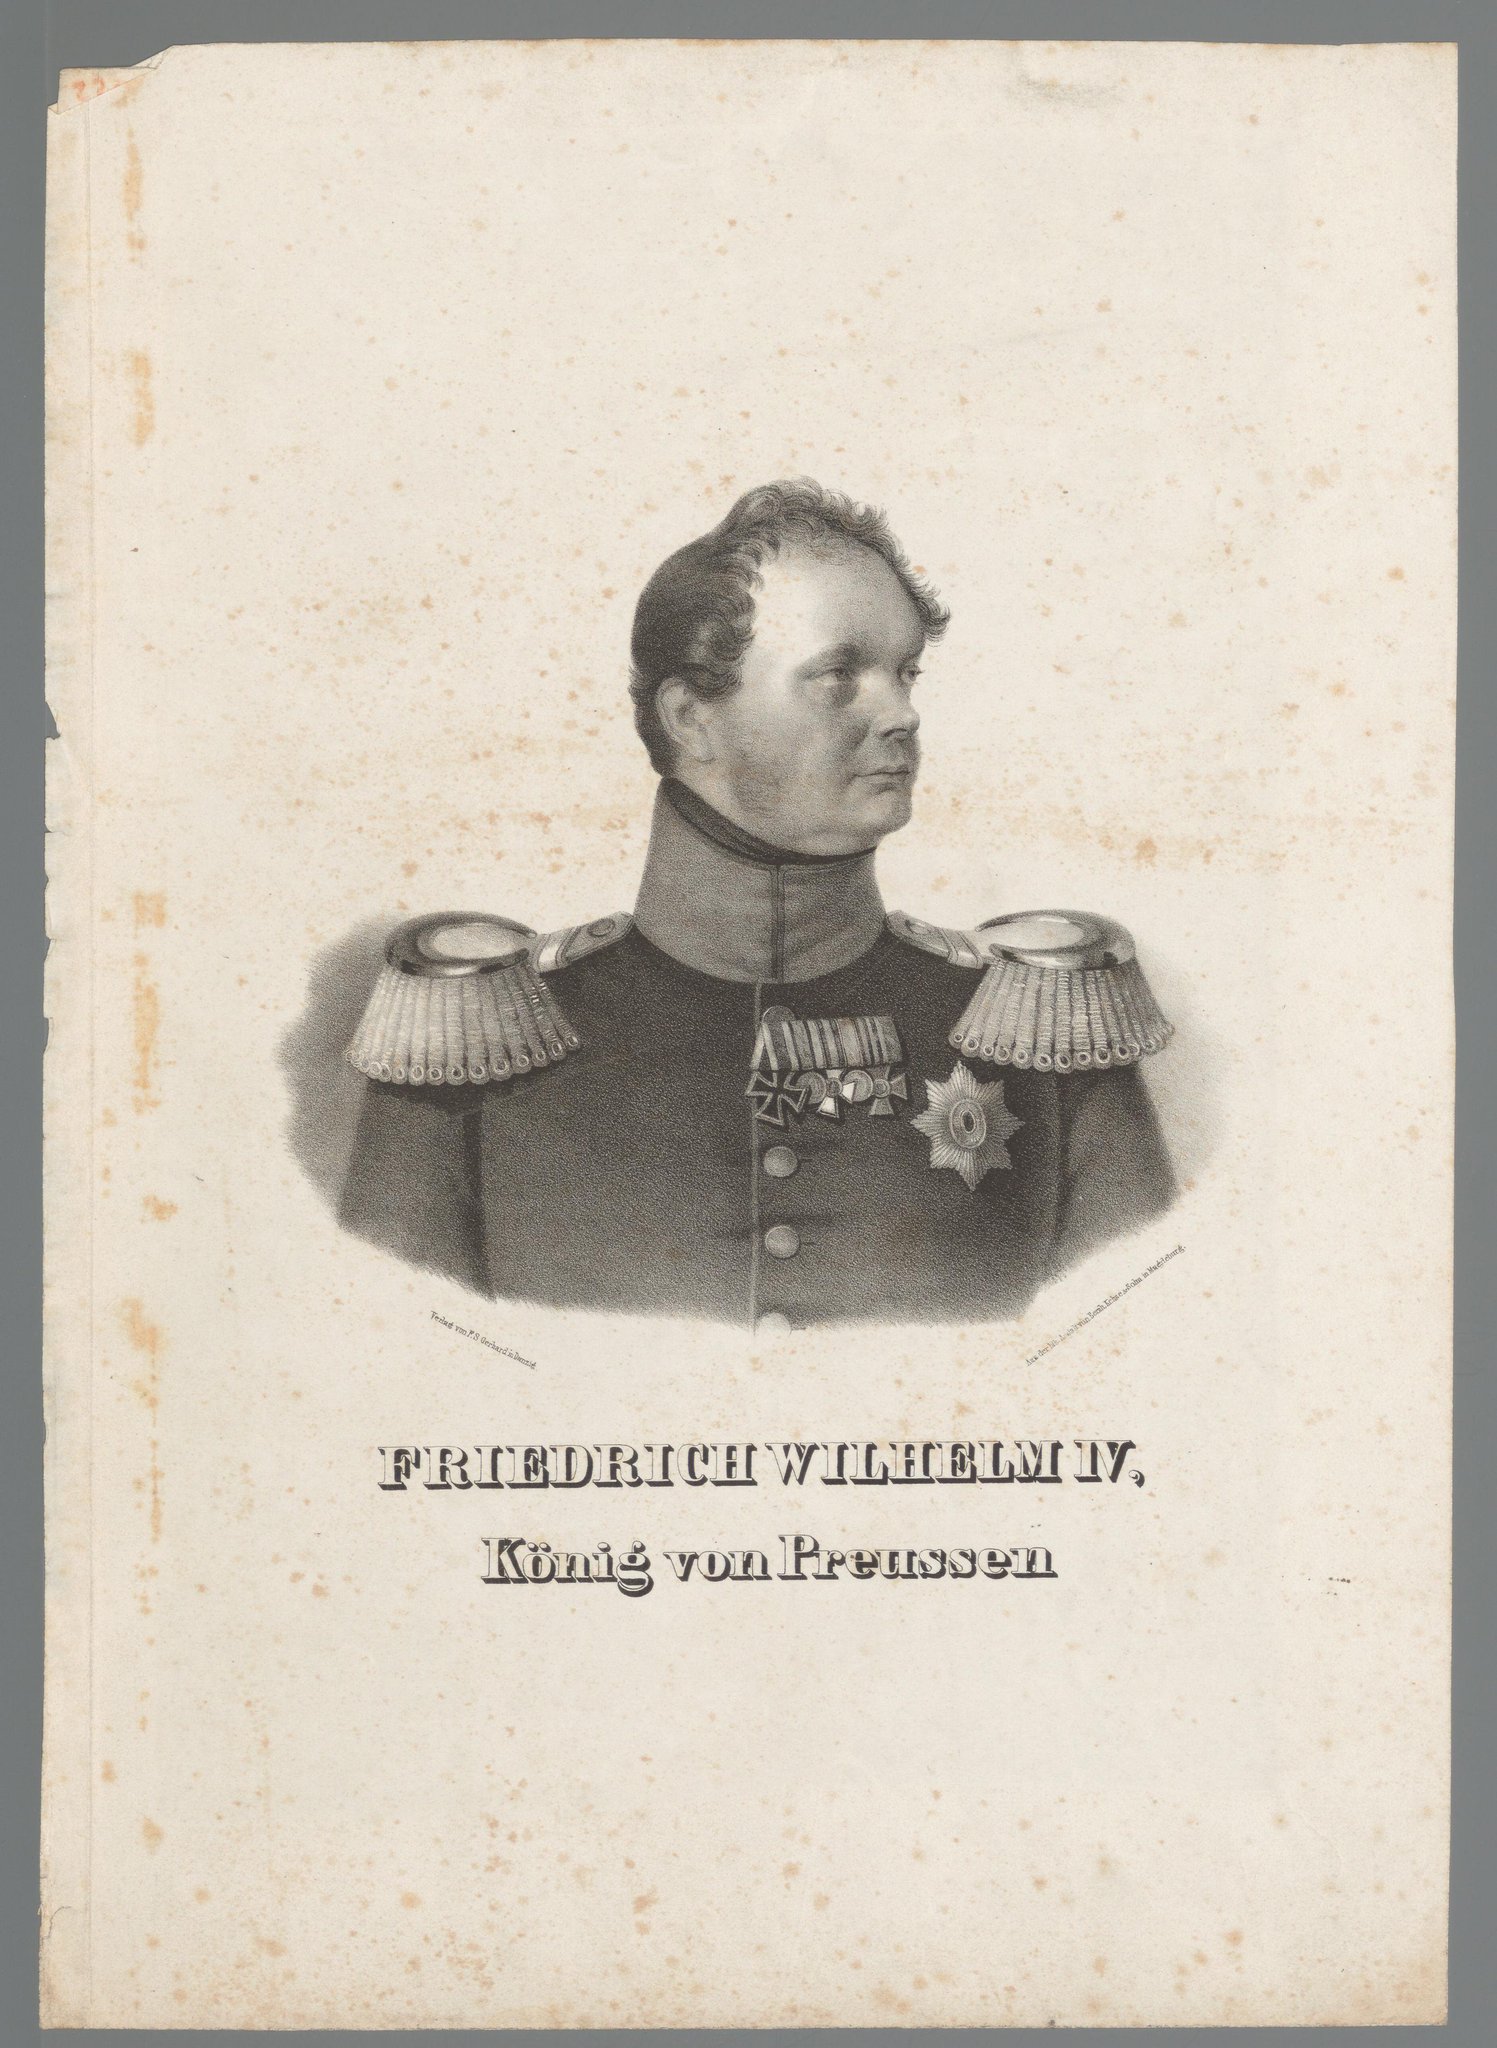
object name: print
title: Portret van Frederik Willem IV, koning van Pruisen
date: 1830-1840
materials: paper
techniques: lithograph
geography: magdeburg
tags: berlin, frederik willem iv (koning van pruisen), adult man, historical persons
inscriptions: collector's mark: Lugt 2228